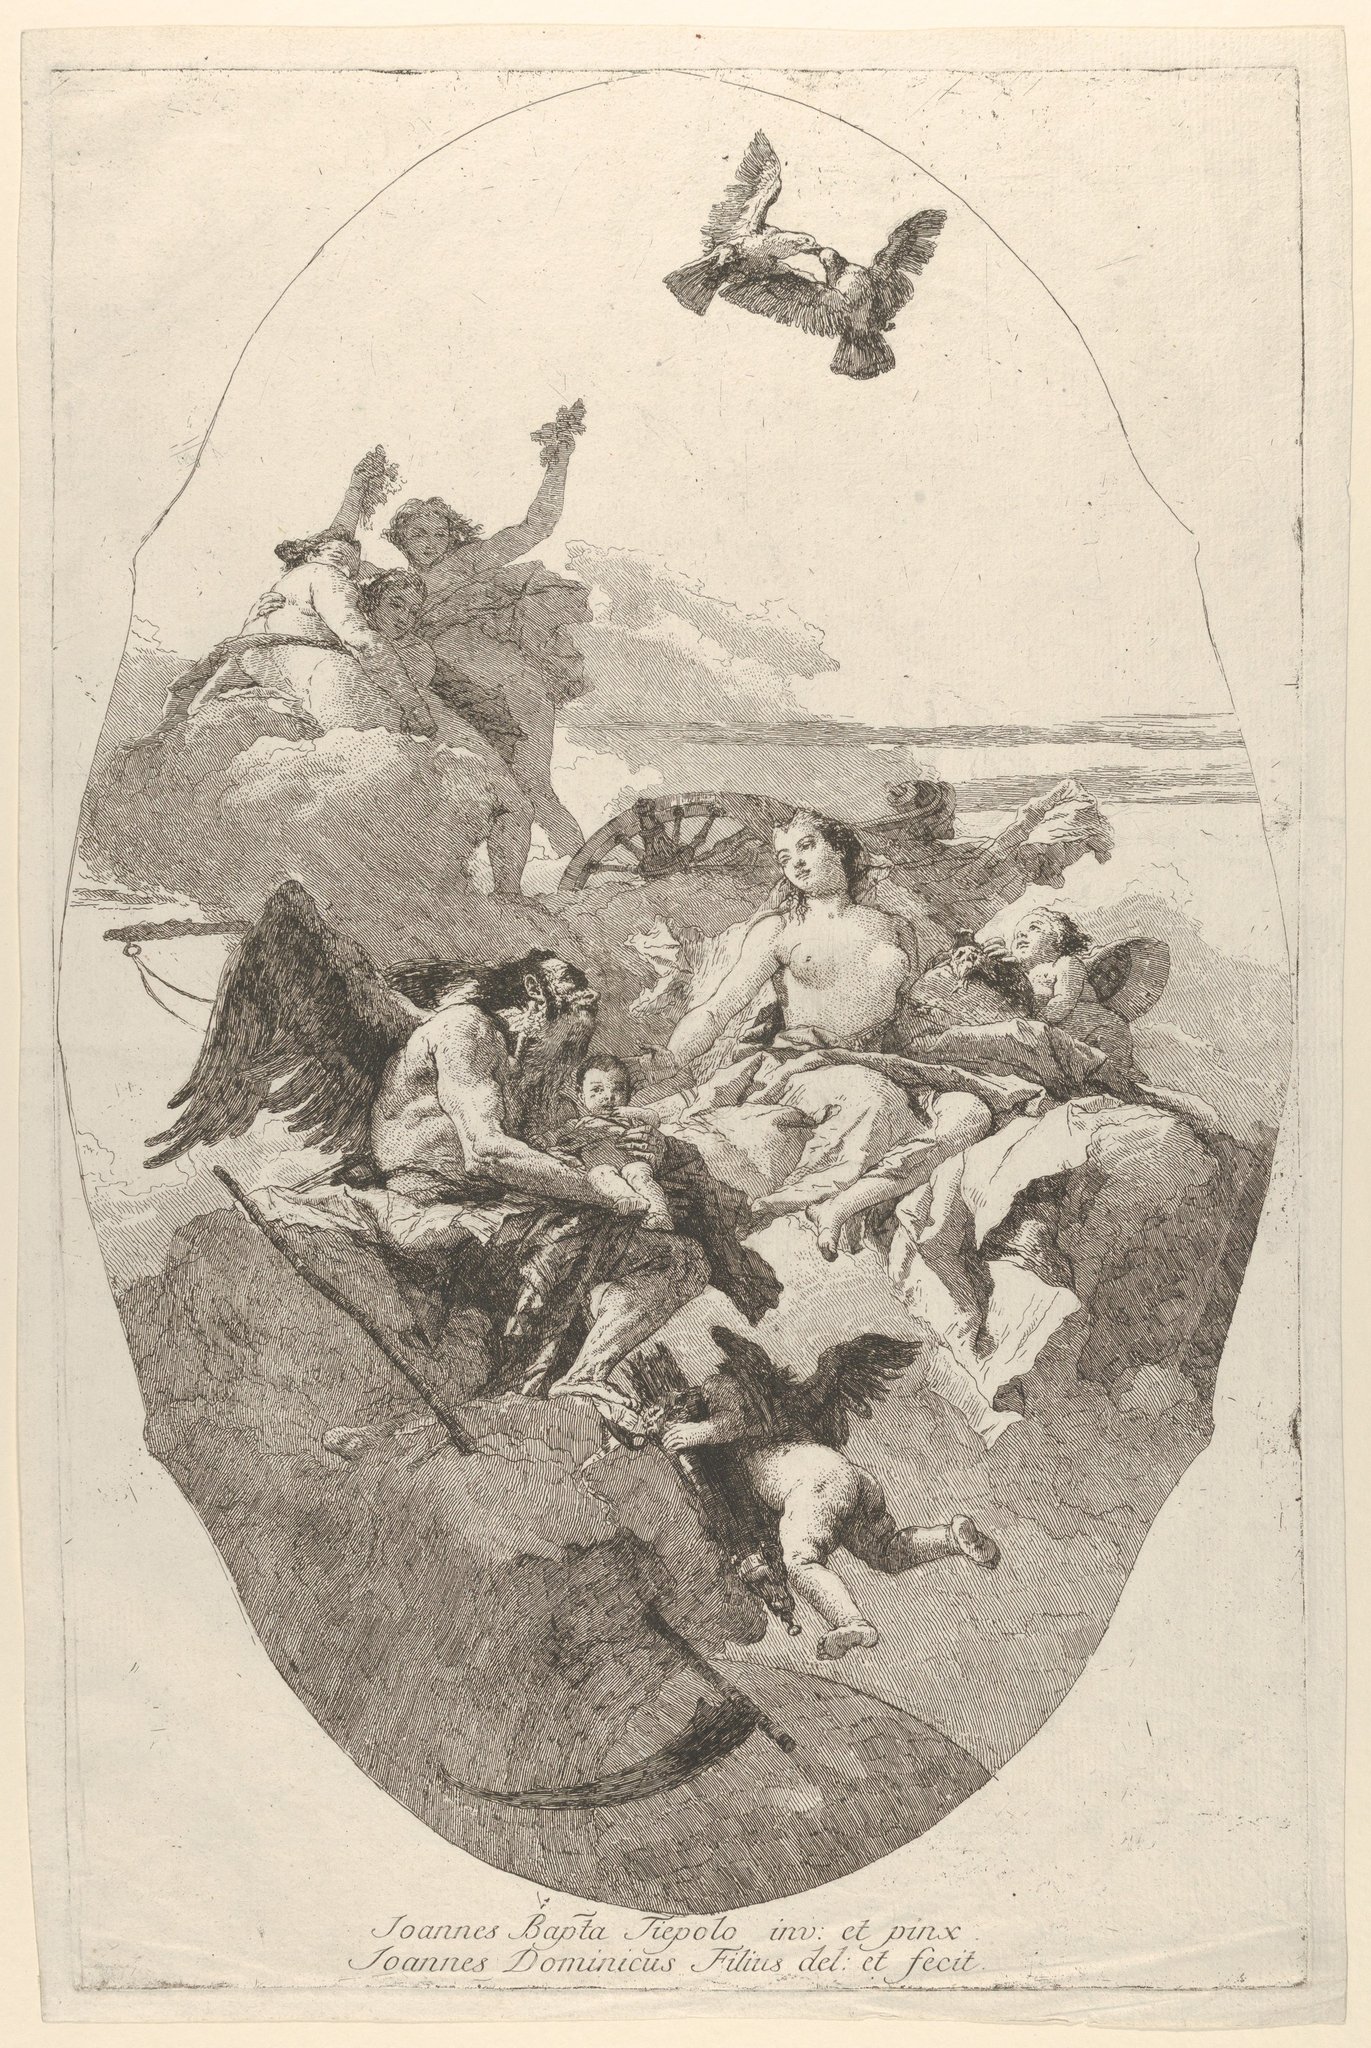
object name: print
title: Venus entrusting Cupid to Time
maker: giovanni domenico tiepolo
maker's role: artist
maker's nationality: italian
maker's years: 1727-1804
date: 1758-1780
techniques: etching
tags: doves,women,female nudes,cupid,venus